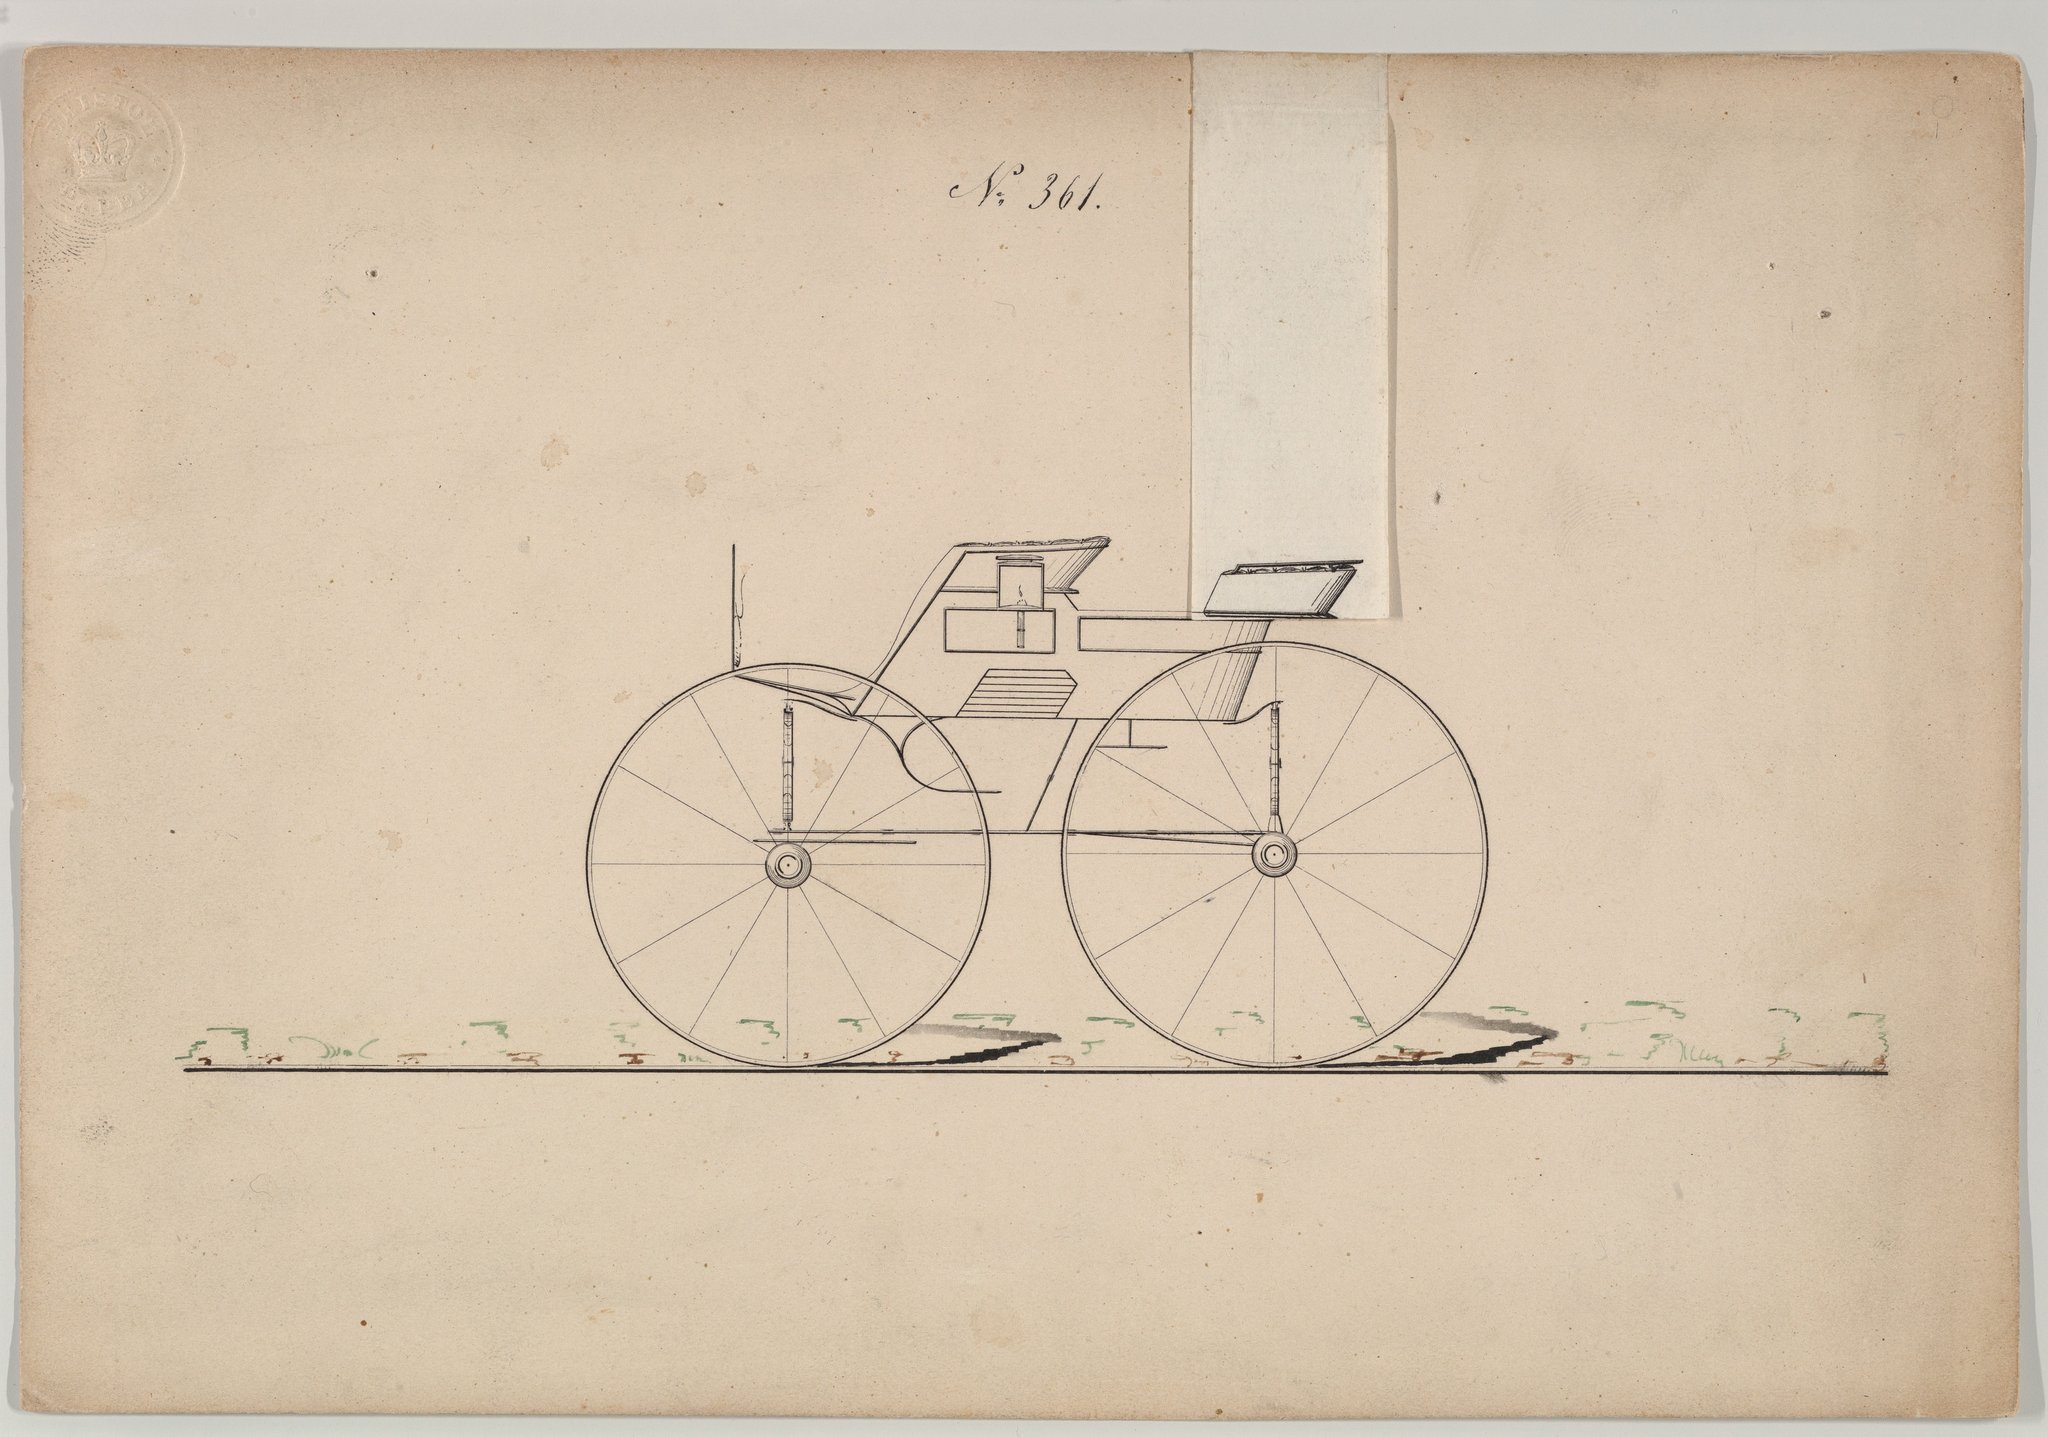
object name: drawing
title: Dog Cart Phaeton #361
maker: brewster & co.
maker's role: manufacturer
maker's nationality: american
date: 1865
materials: gouache, ink, watercolor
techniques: pen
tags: carriages